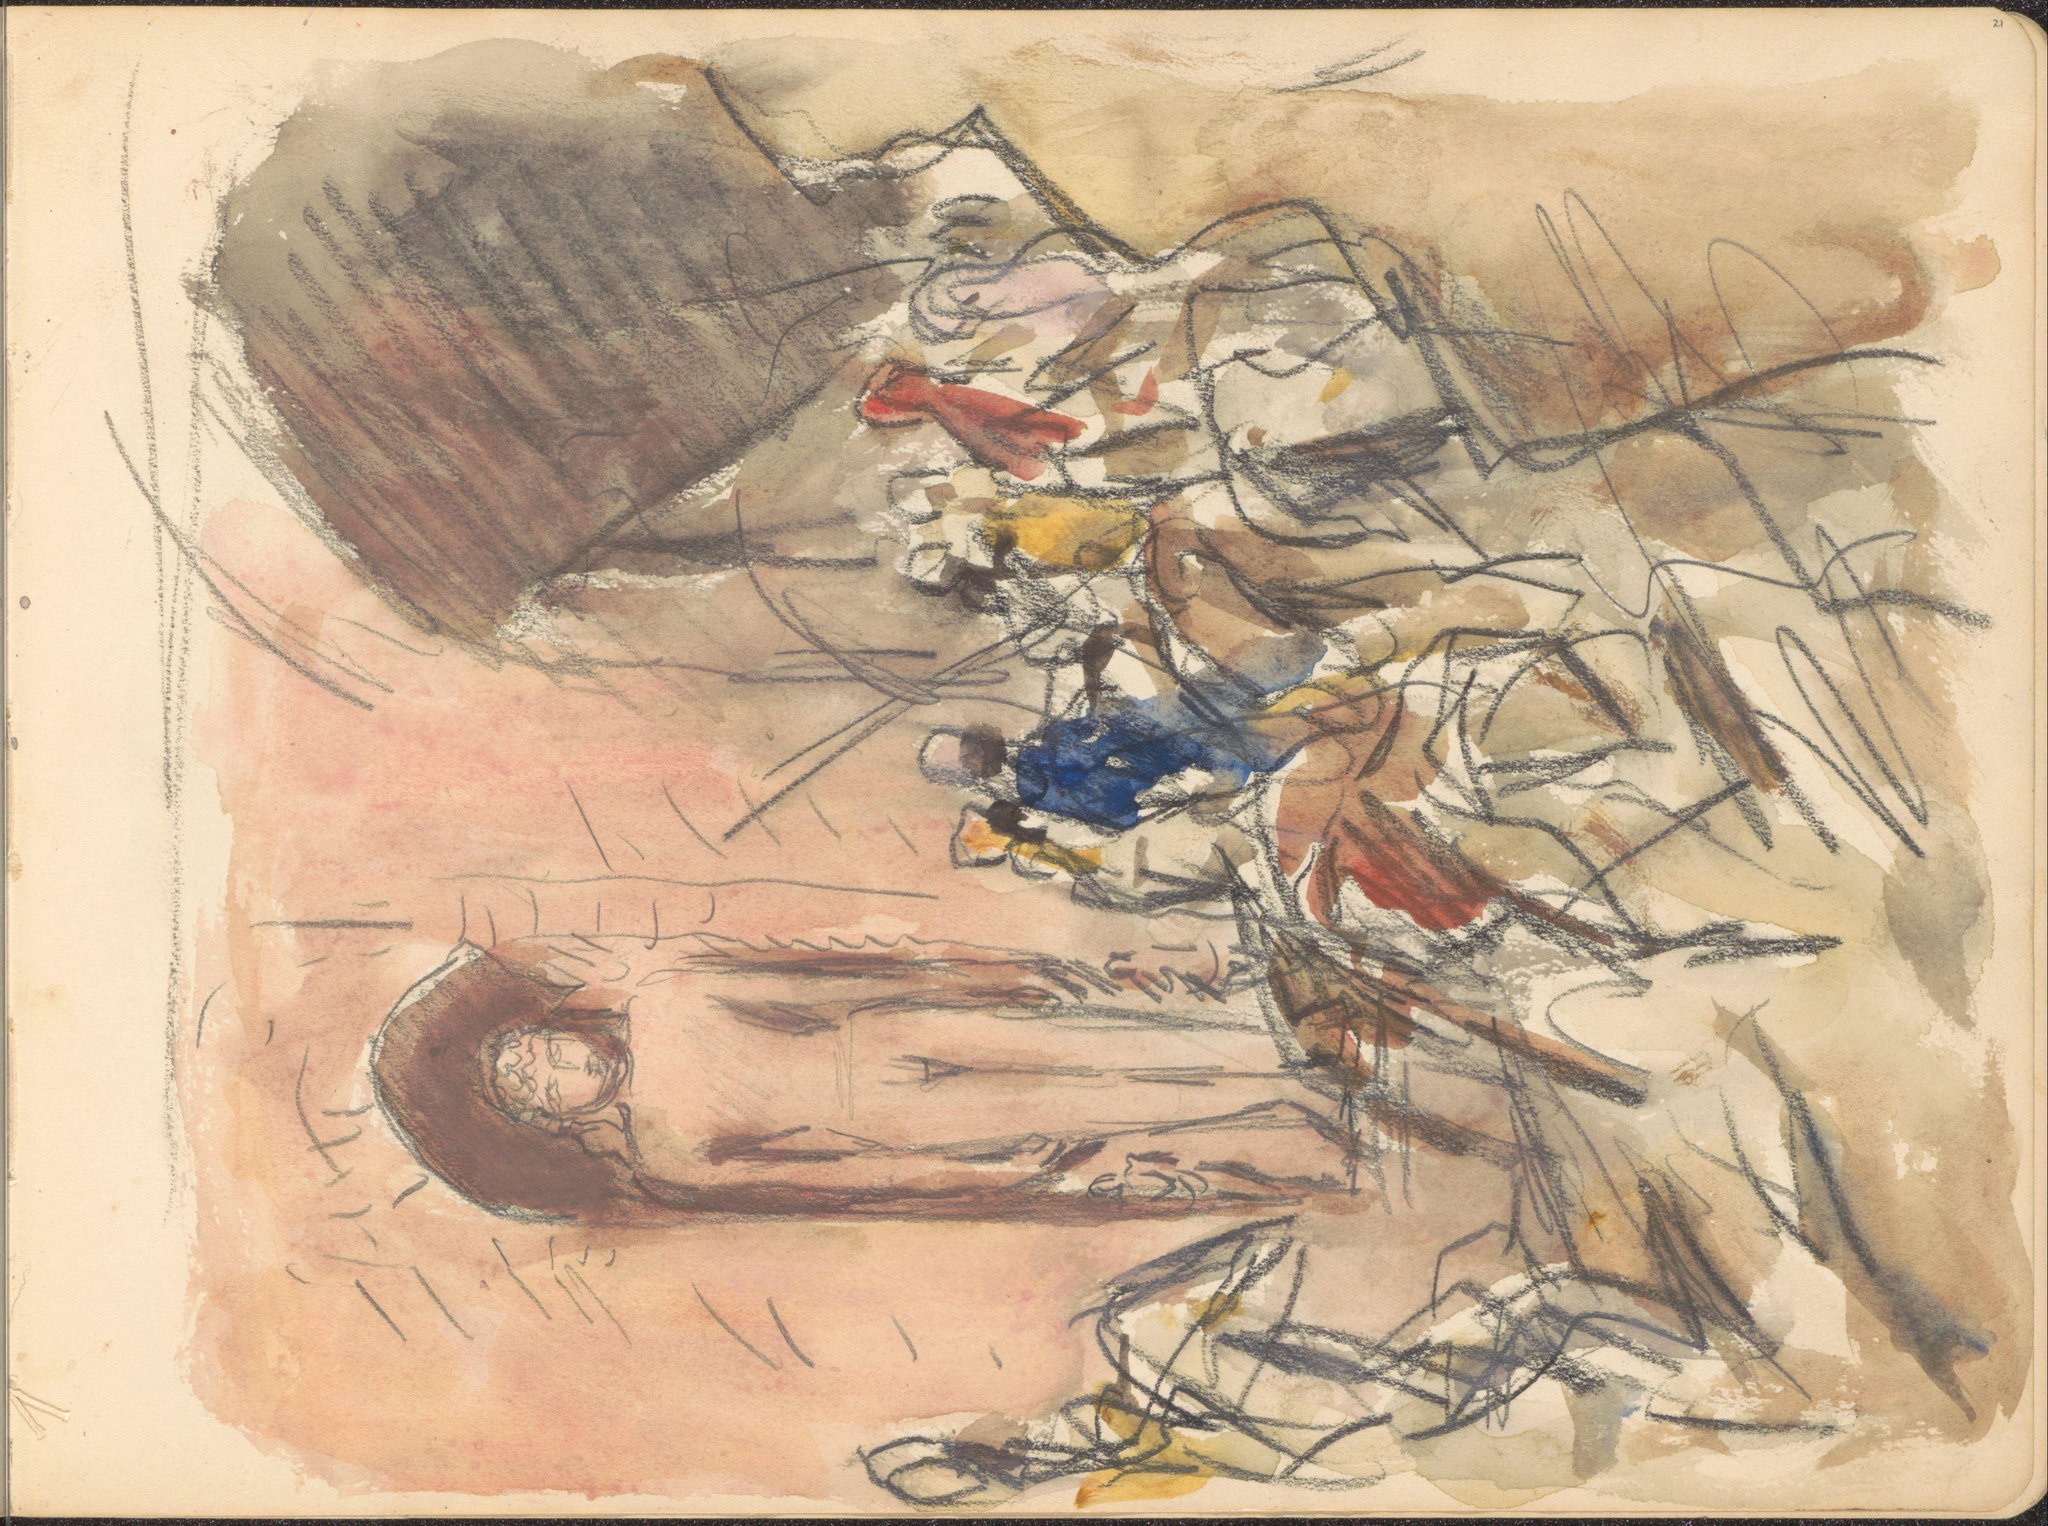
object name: sketchbook leaf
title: Optocht van ruiters voor een nis met een beeld van een Hindoeïstische god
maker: marius bauer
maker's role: draughtsman, print maker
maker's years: 1867-1932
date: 1924-1925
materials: chalk, paper, watercolor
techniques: brush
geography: sri lanka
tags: riding a horse, ass, or mule; rider, horseman, statues, paintings, etc. ~ objects of worship (hinduism, buddhism, jainism), street (+ city(-scape) with figures, staffage)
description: Pagina 21 uit een schetsboek met 20 bladen.